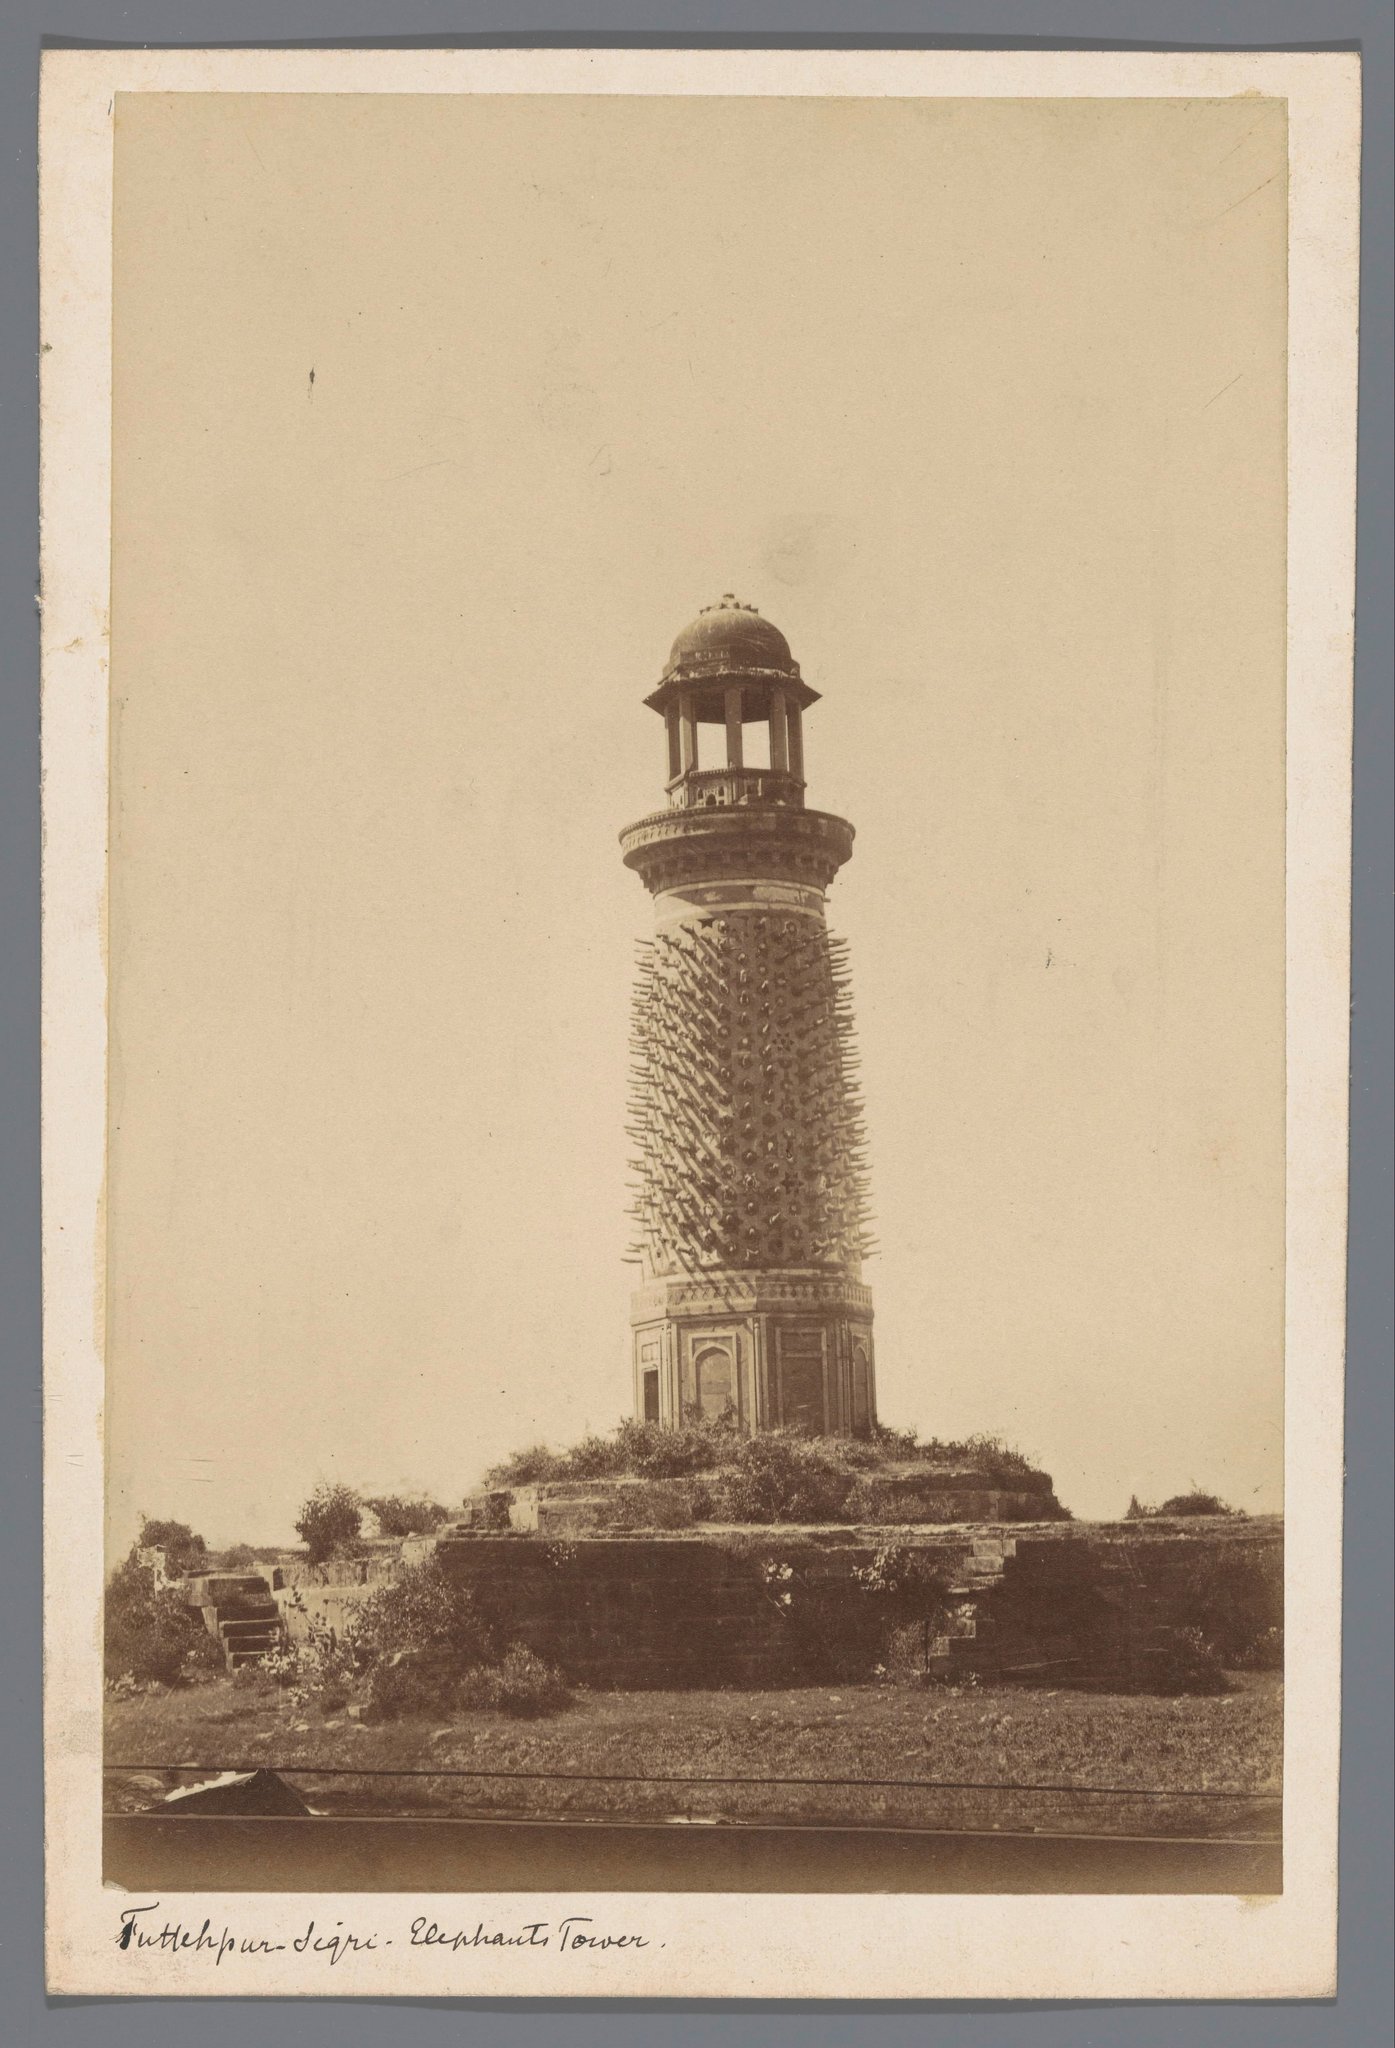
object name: photograph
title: Hiran Minar at Fatehpur Sikri, Uttar Pradesh, India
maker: Anonymous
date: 1860-1890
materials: cardboard, paper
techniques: albumen print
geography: fatehpur sikri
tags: tower, clock tower ~ monumental adornment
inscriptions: title: ‘Futtehpur-Siqri - Elephants Tower.’, number: ‘28’